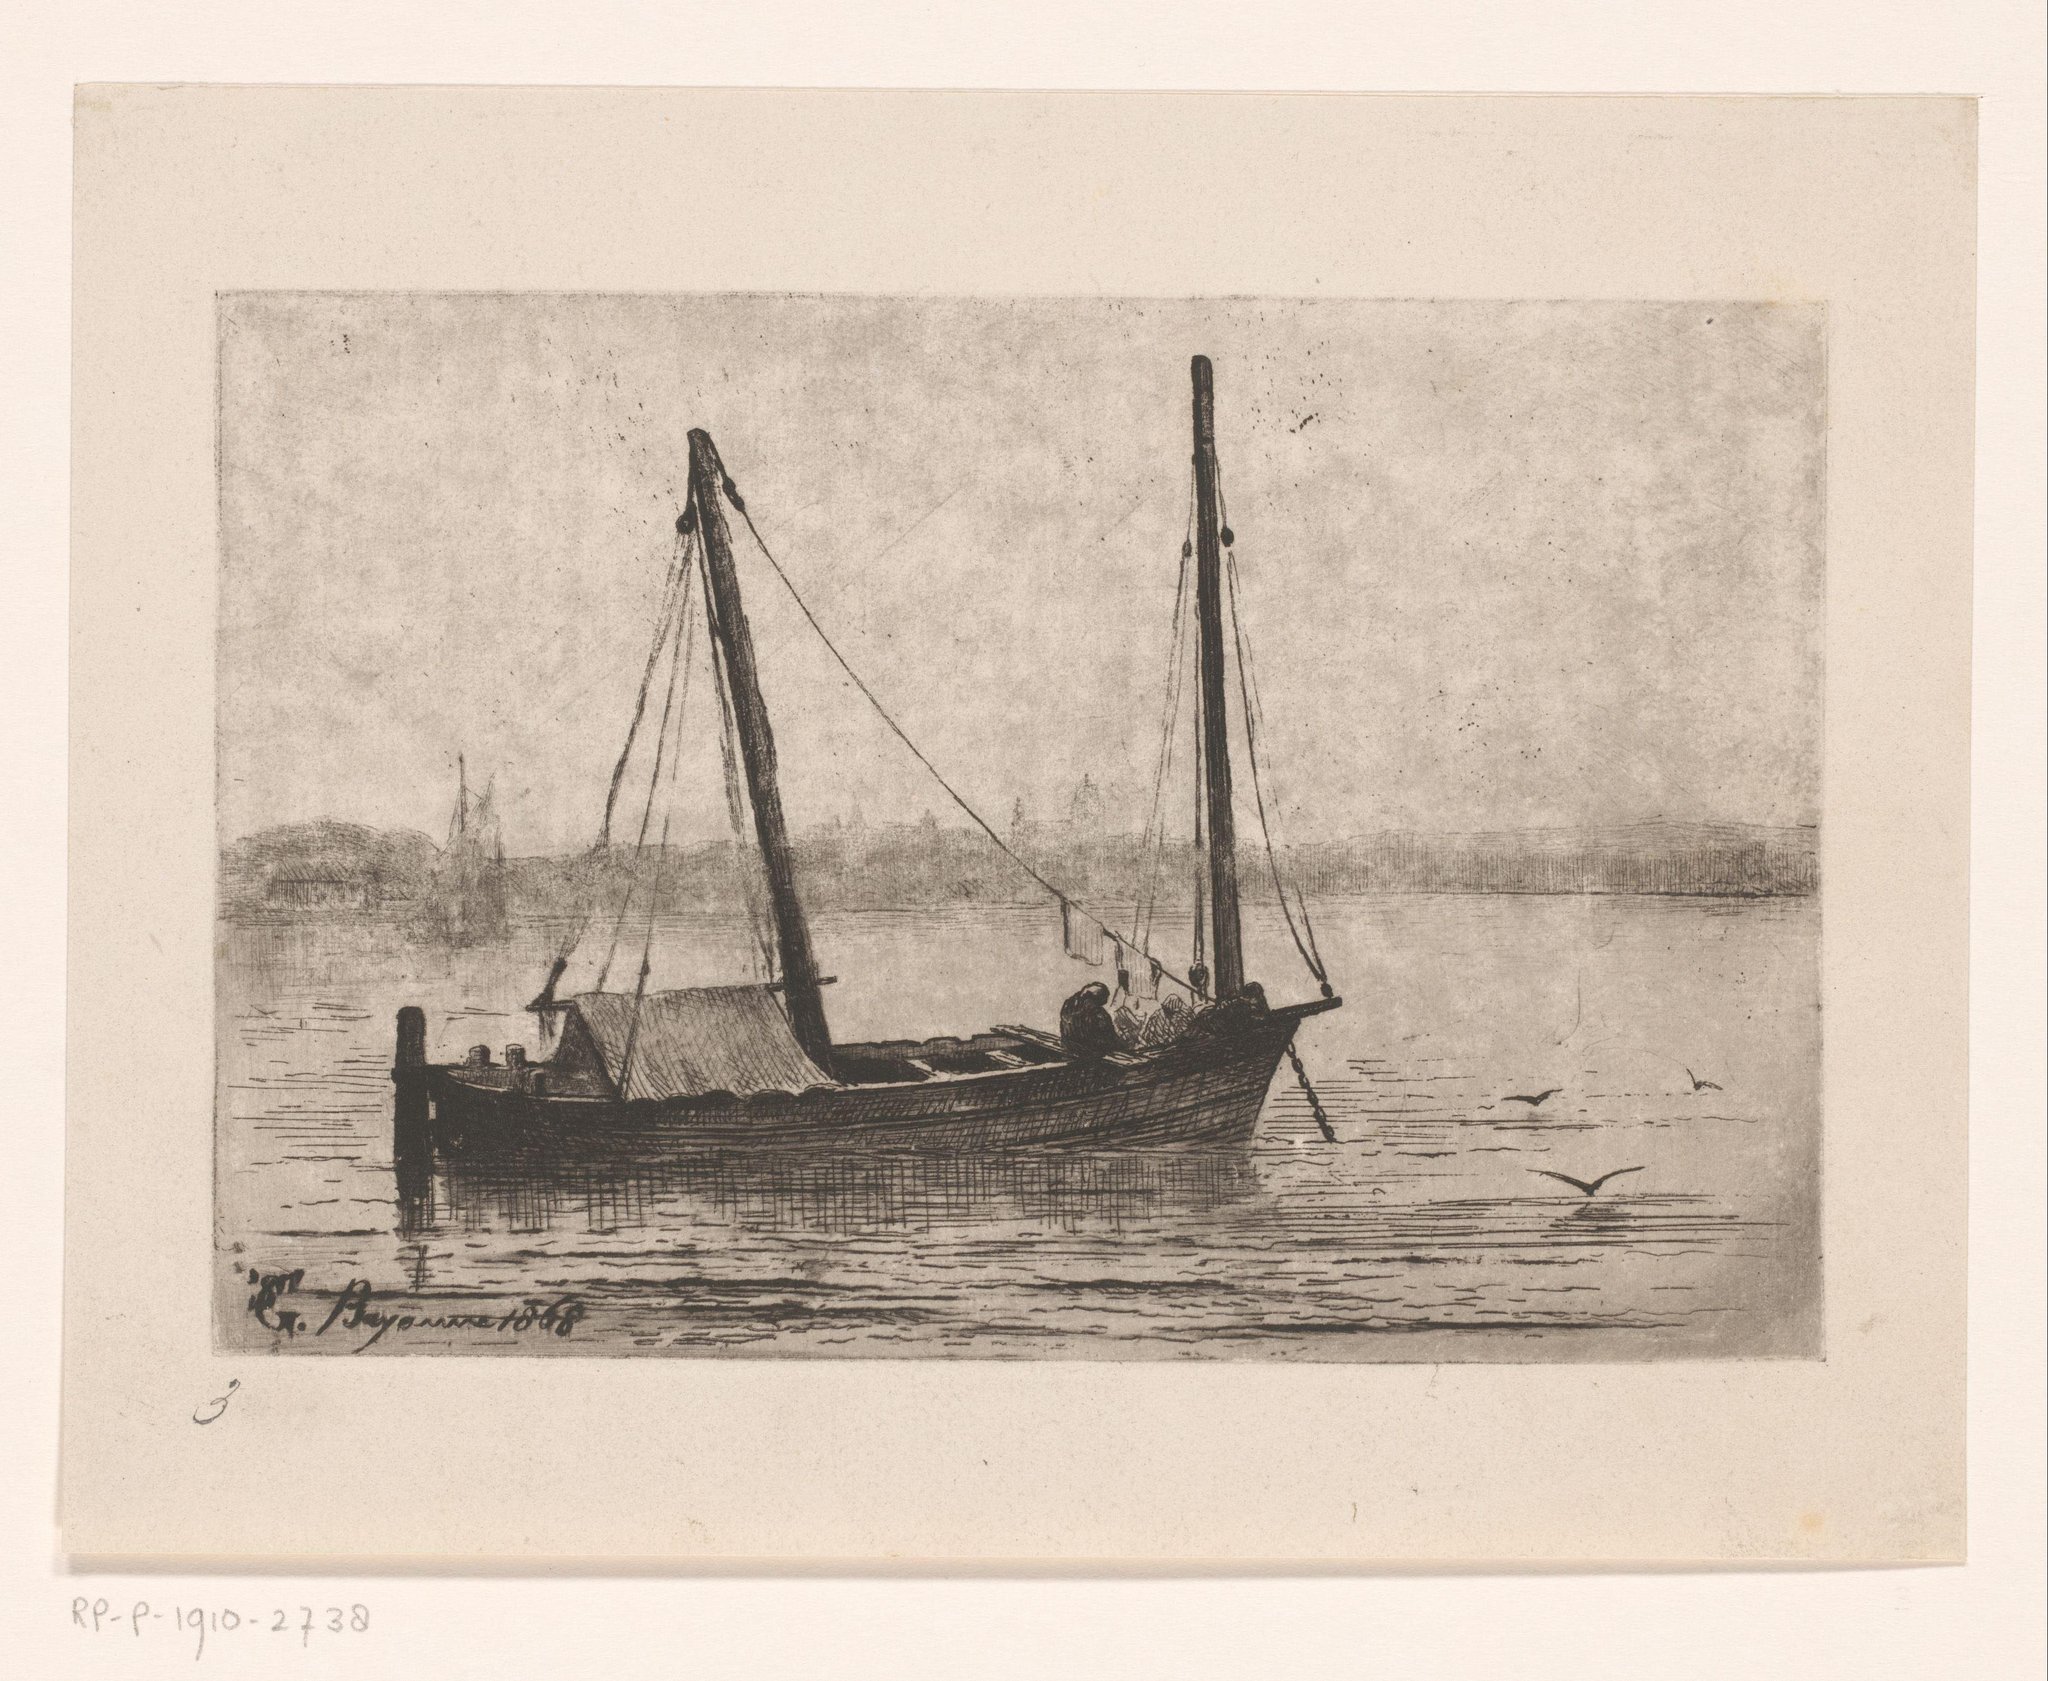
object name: print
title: Boot op de Adour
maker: carel nicolaas storm van s-gravesande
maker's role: draughtsman, print maker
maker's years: 1841-1924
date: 1870-1871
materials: paper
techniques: etching, intaglio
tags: sailing-ship, sailing-boat, river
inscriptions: collector's mark: Lugt 2228